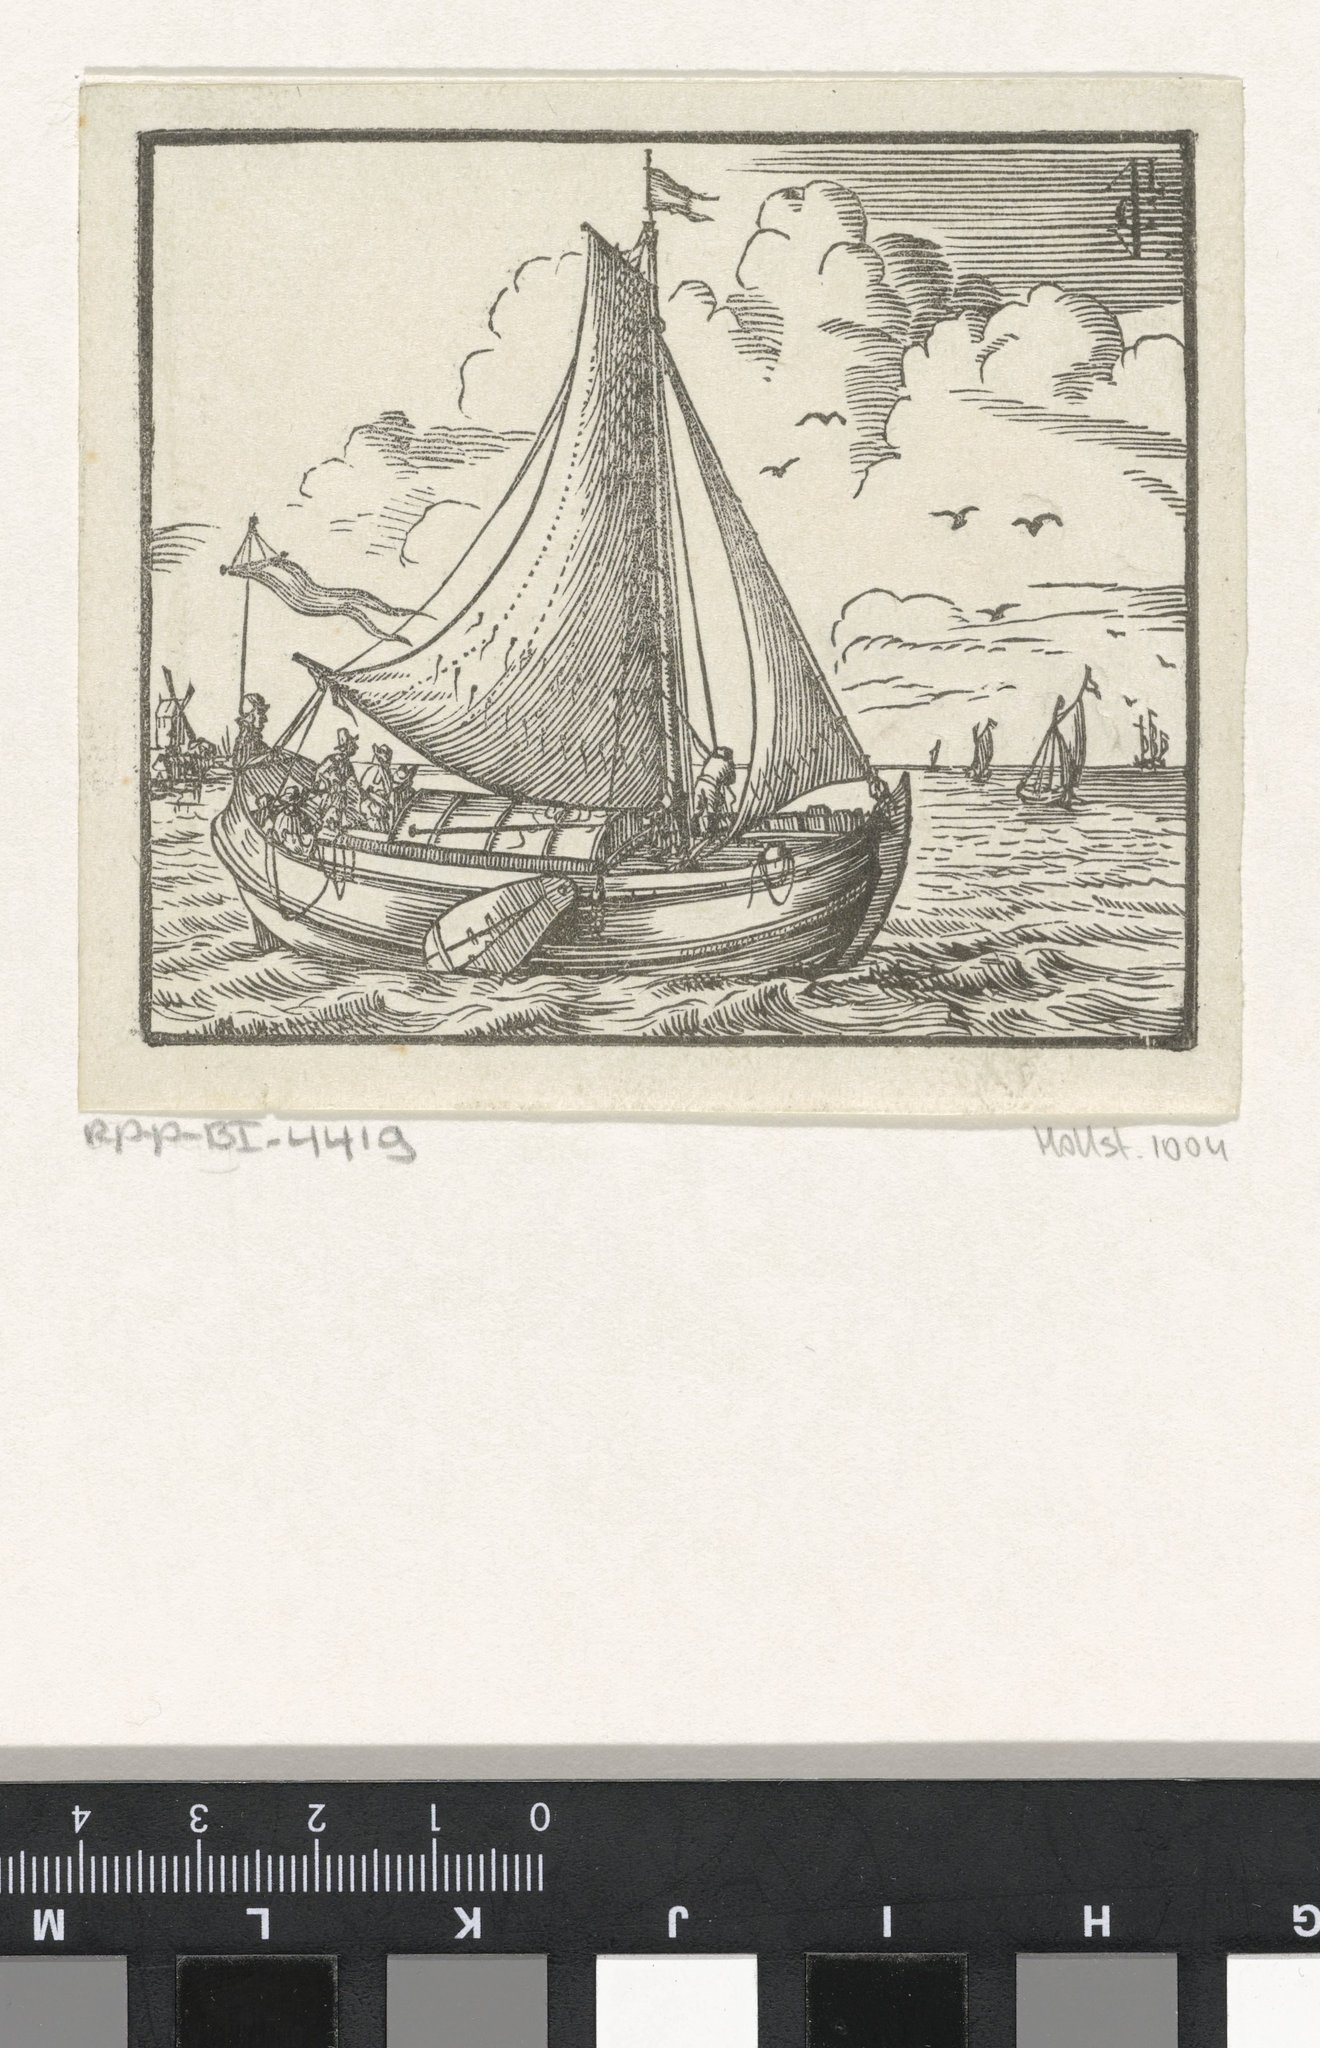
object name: print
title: Zeilschip nabij een kust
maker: isaac vincentsz. van der vinne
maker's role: draughtsman, print maker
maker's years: 1665-1740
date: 1681-1740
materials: paper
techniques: woodcut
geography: haarlem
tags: sailing-ship, sailing-boat, coast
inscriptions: collector's mark: Lugt 240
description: Rechtsboven het monogram van de uitgever Abraham Casteleyn.